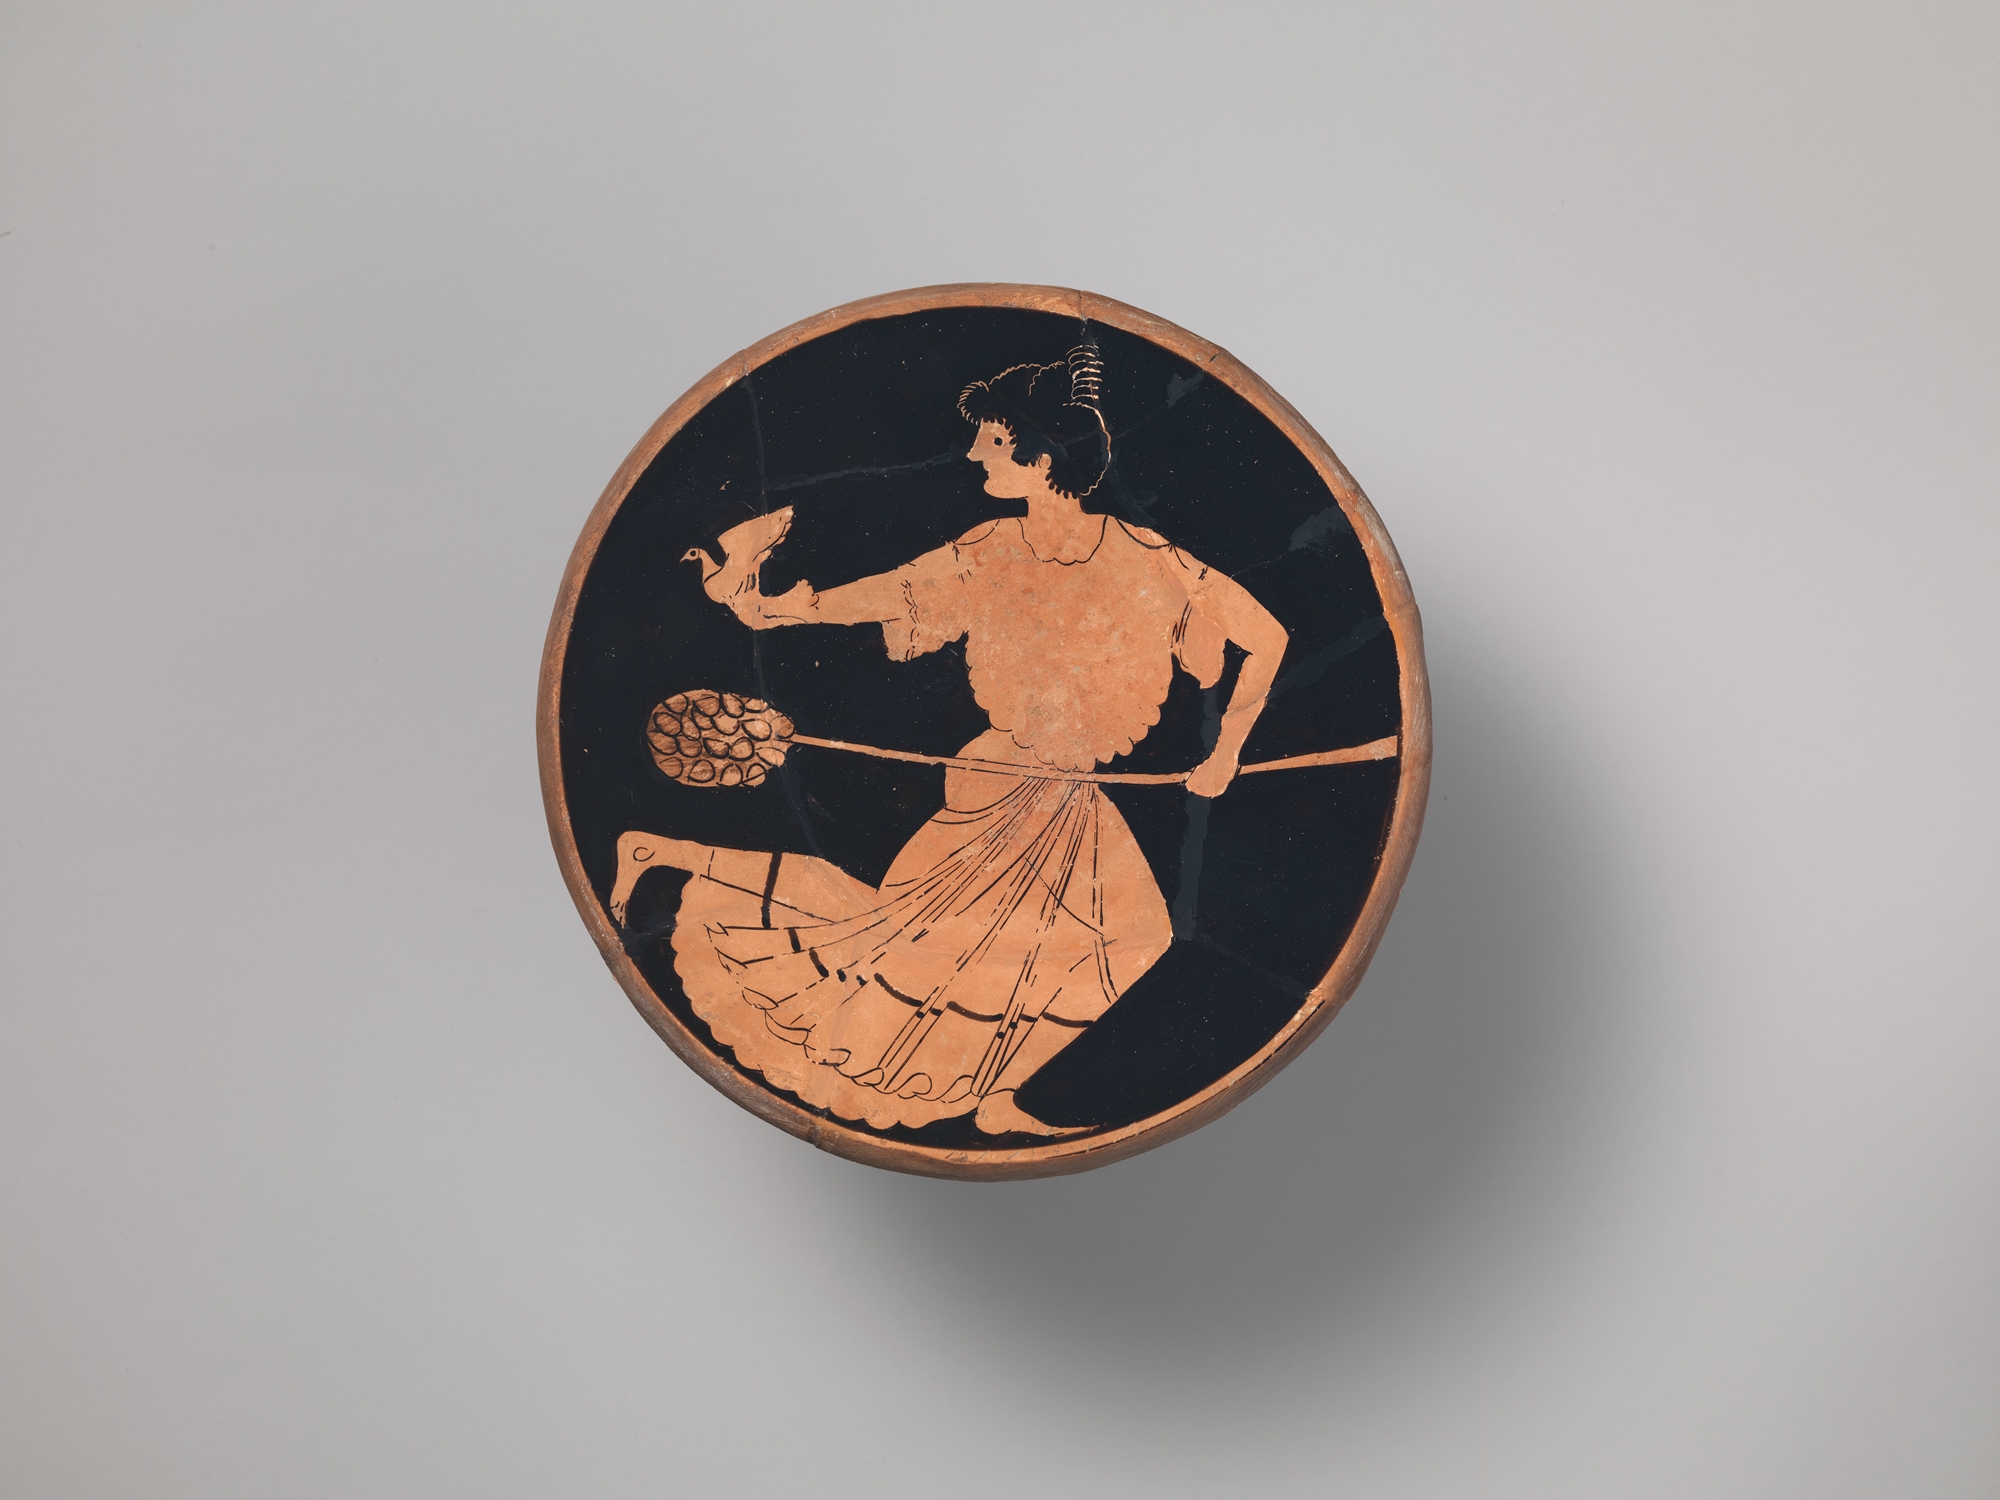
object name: kylix, fragmentary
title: Terracotta kylix (drinking cup)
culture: greek, attic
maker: poseidon painter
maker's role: artist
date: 510-500 BCE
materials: terracotta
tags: birds,maenads